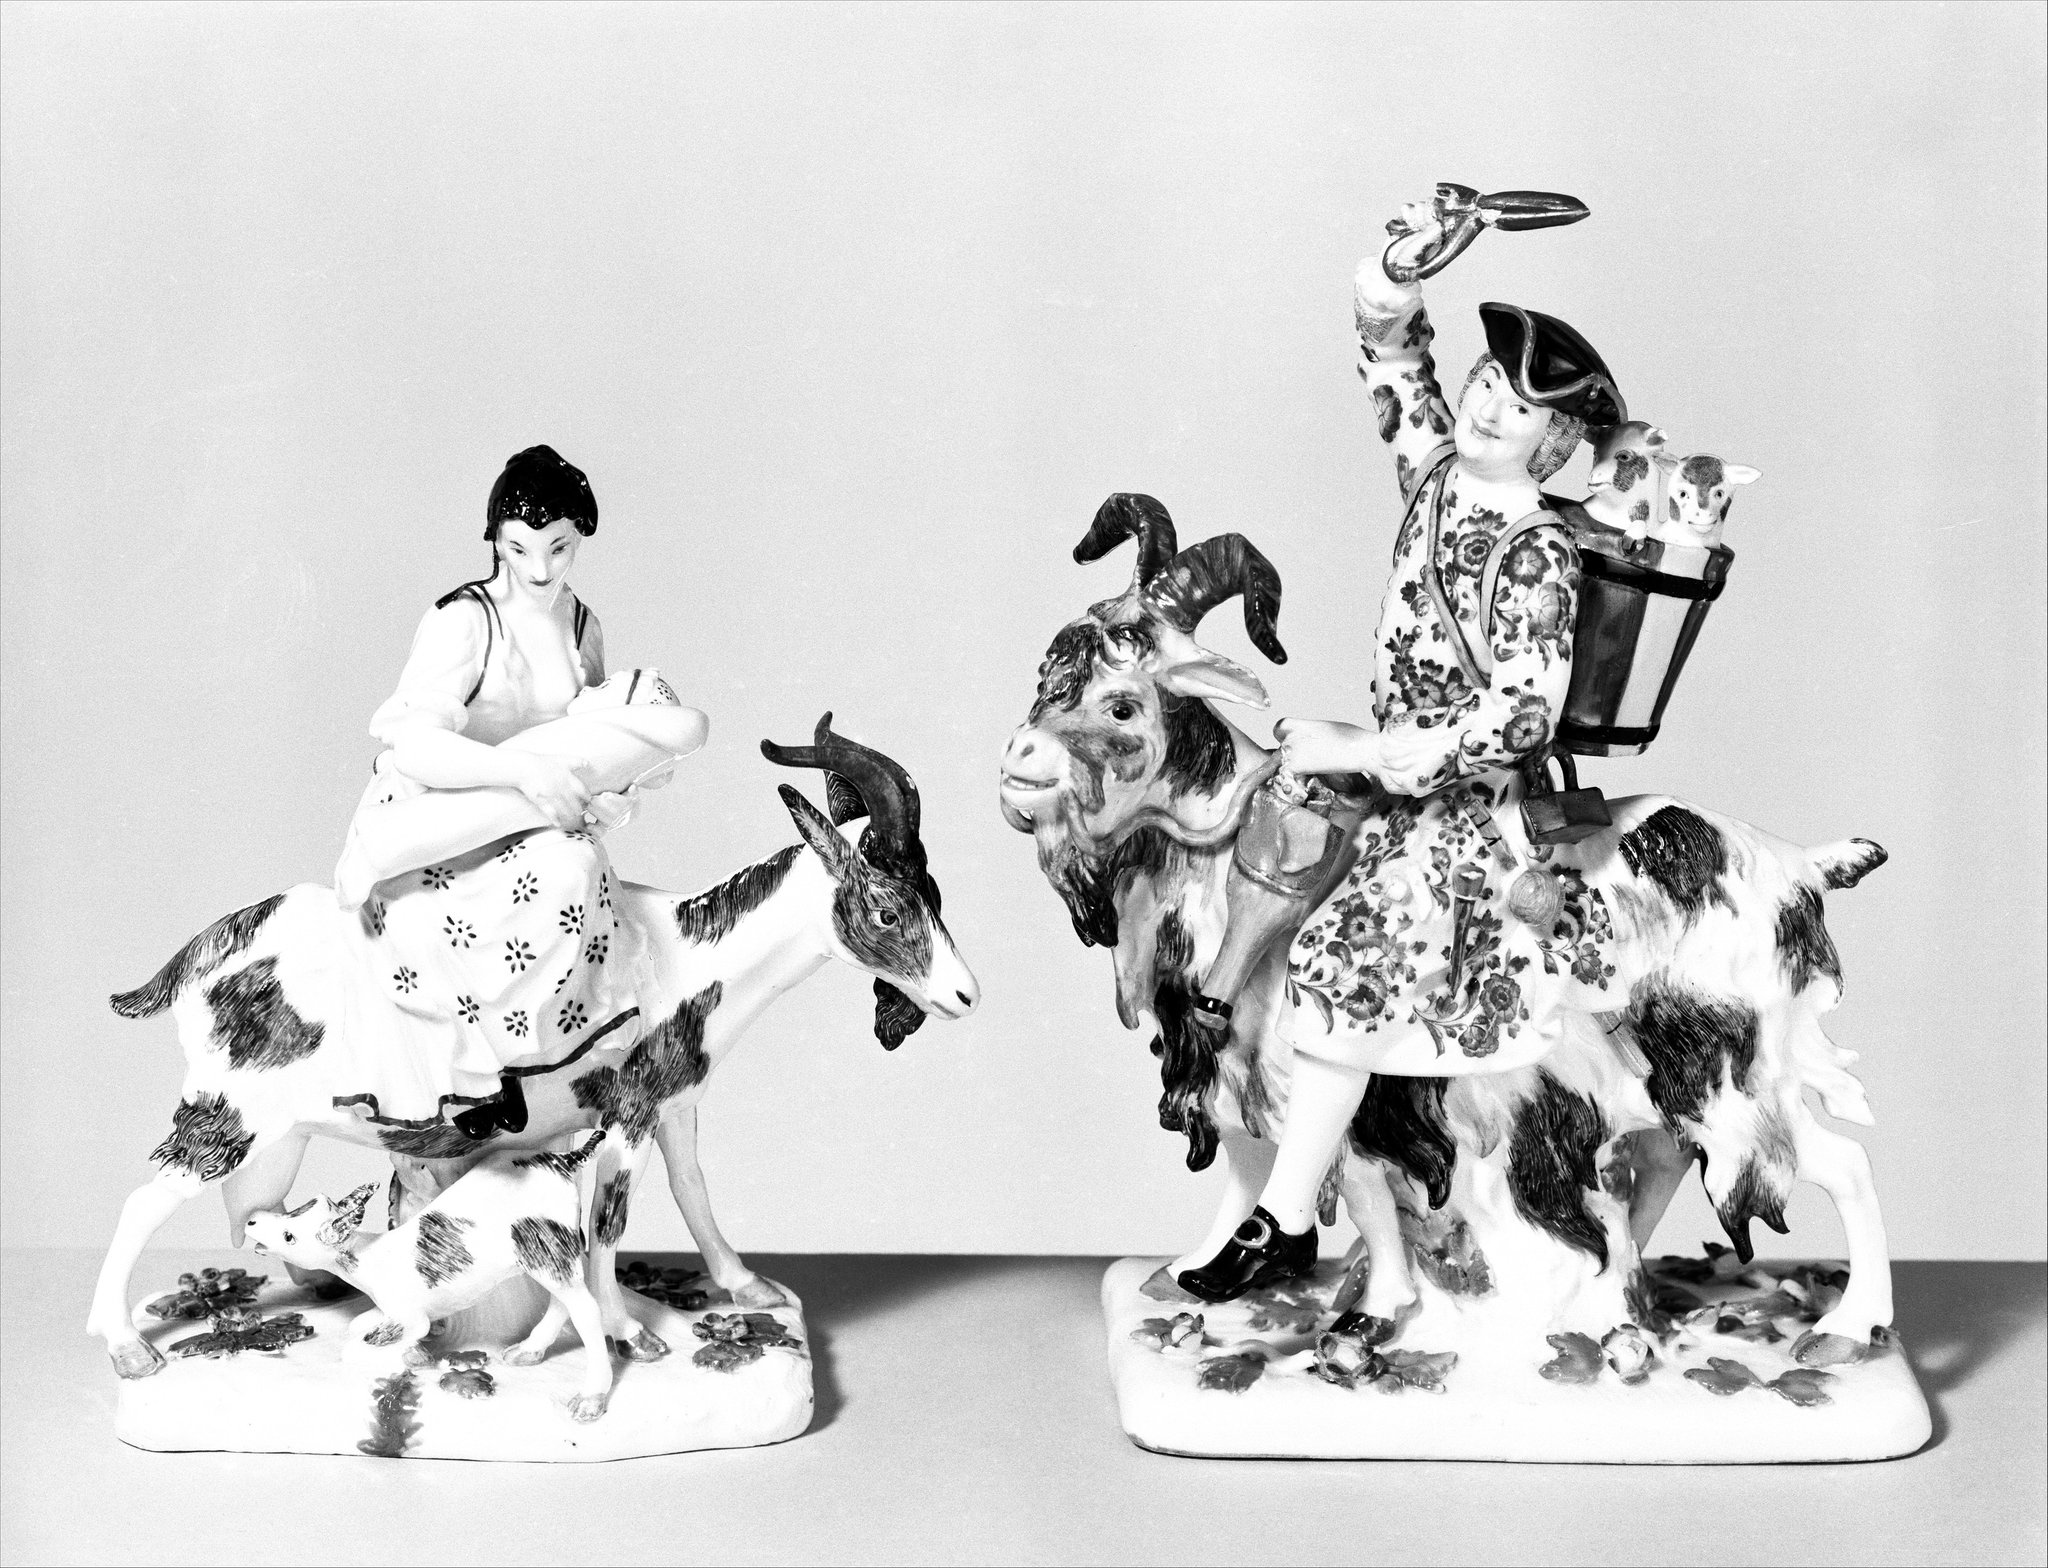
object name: group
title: Tailor's wife riding a goat (one of a pair)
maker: meissen manufactory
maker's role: manufactory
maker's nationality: german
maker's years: 1710-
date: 1740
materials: hard paste porcelain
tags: infants,men,women,goats